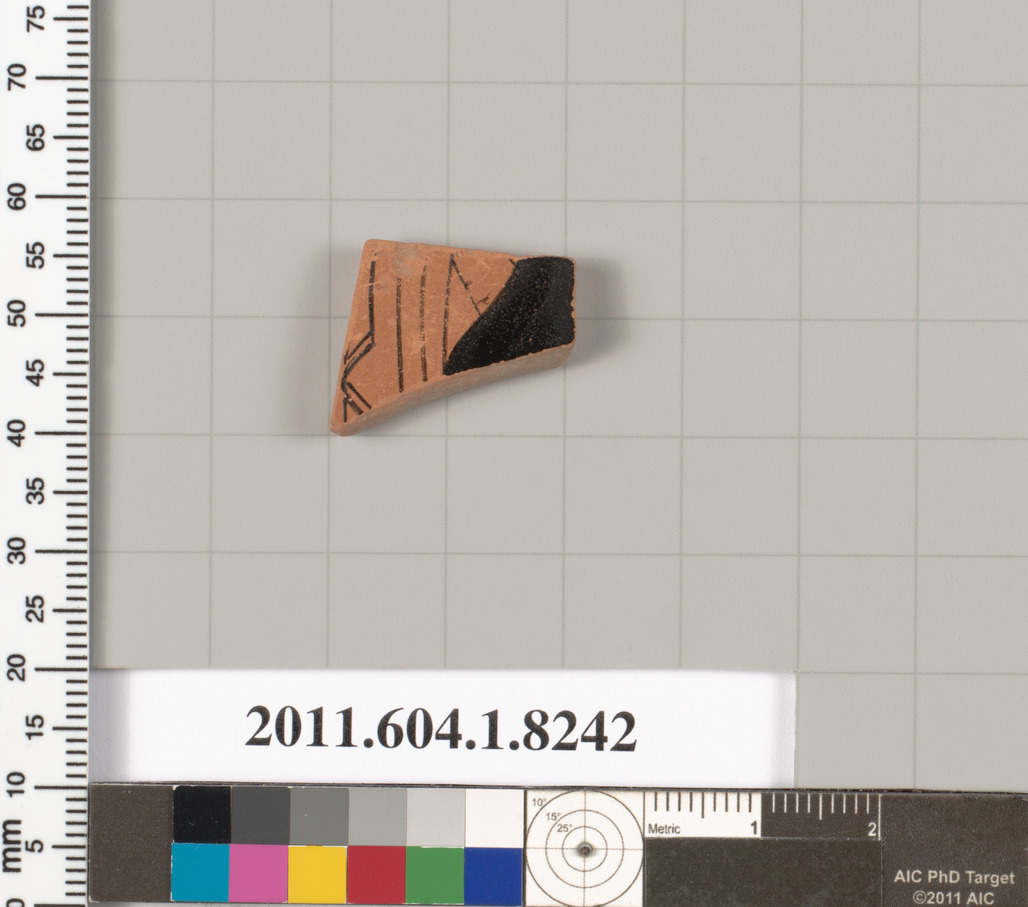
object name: kylix fragment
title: Terracotta fragment of a kylix (drinking cup)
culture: greek, attic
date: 520-510 BCE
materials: terracotta